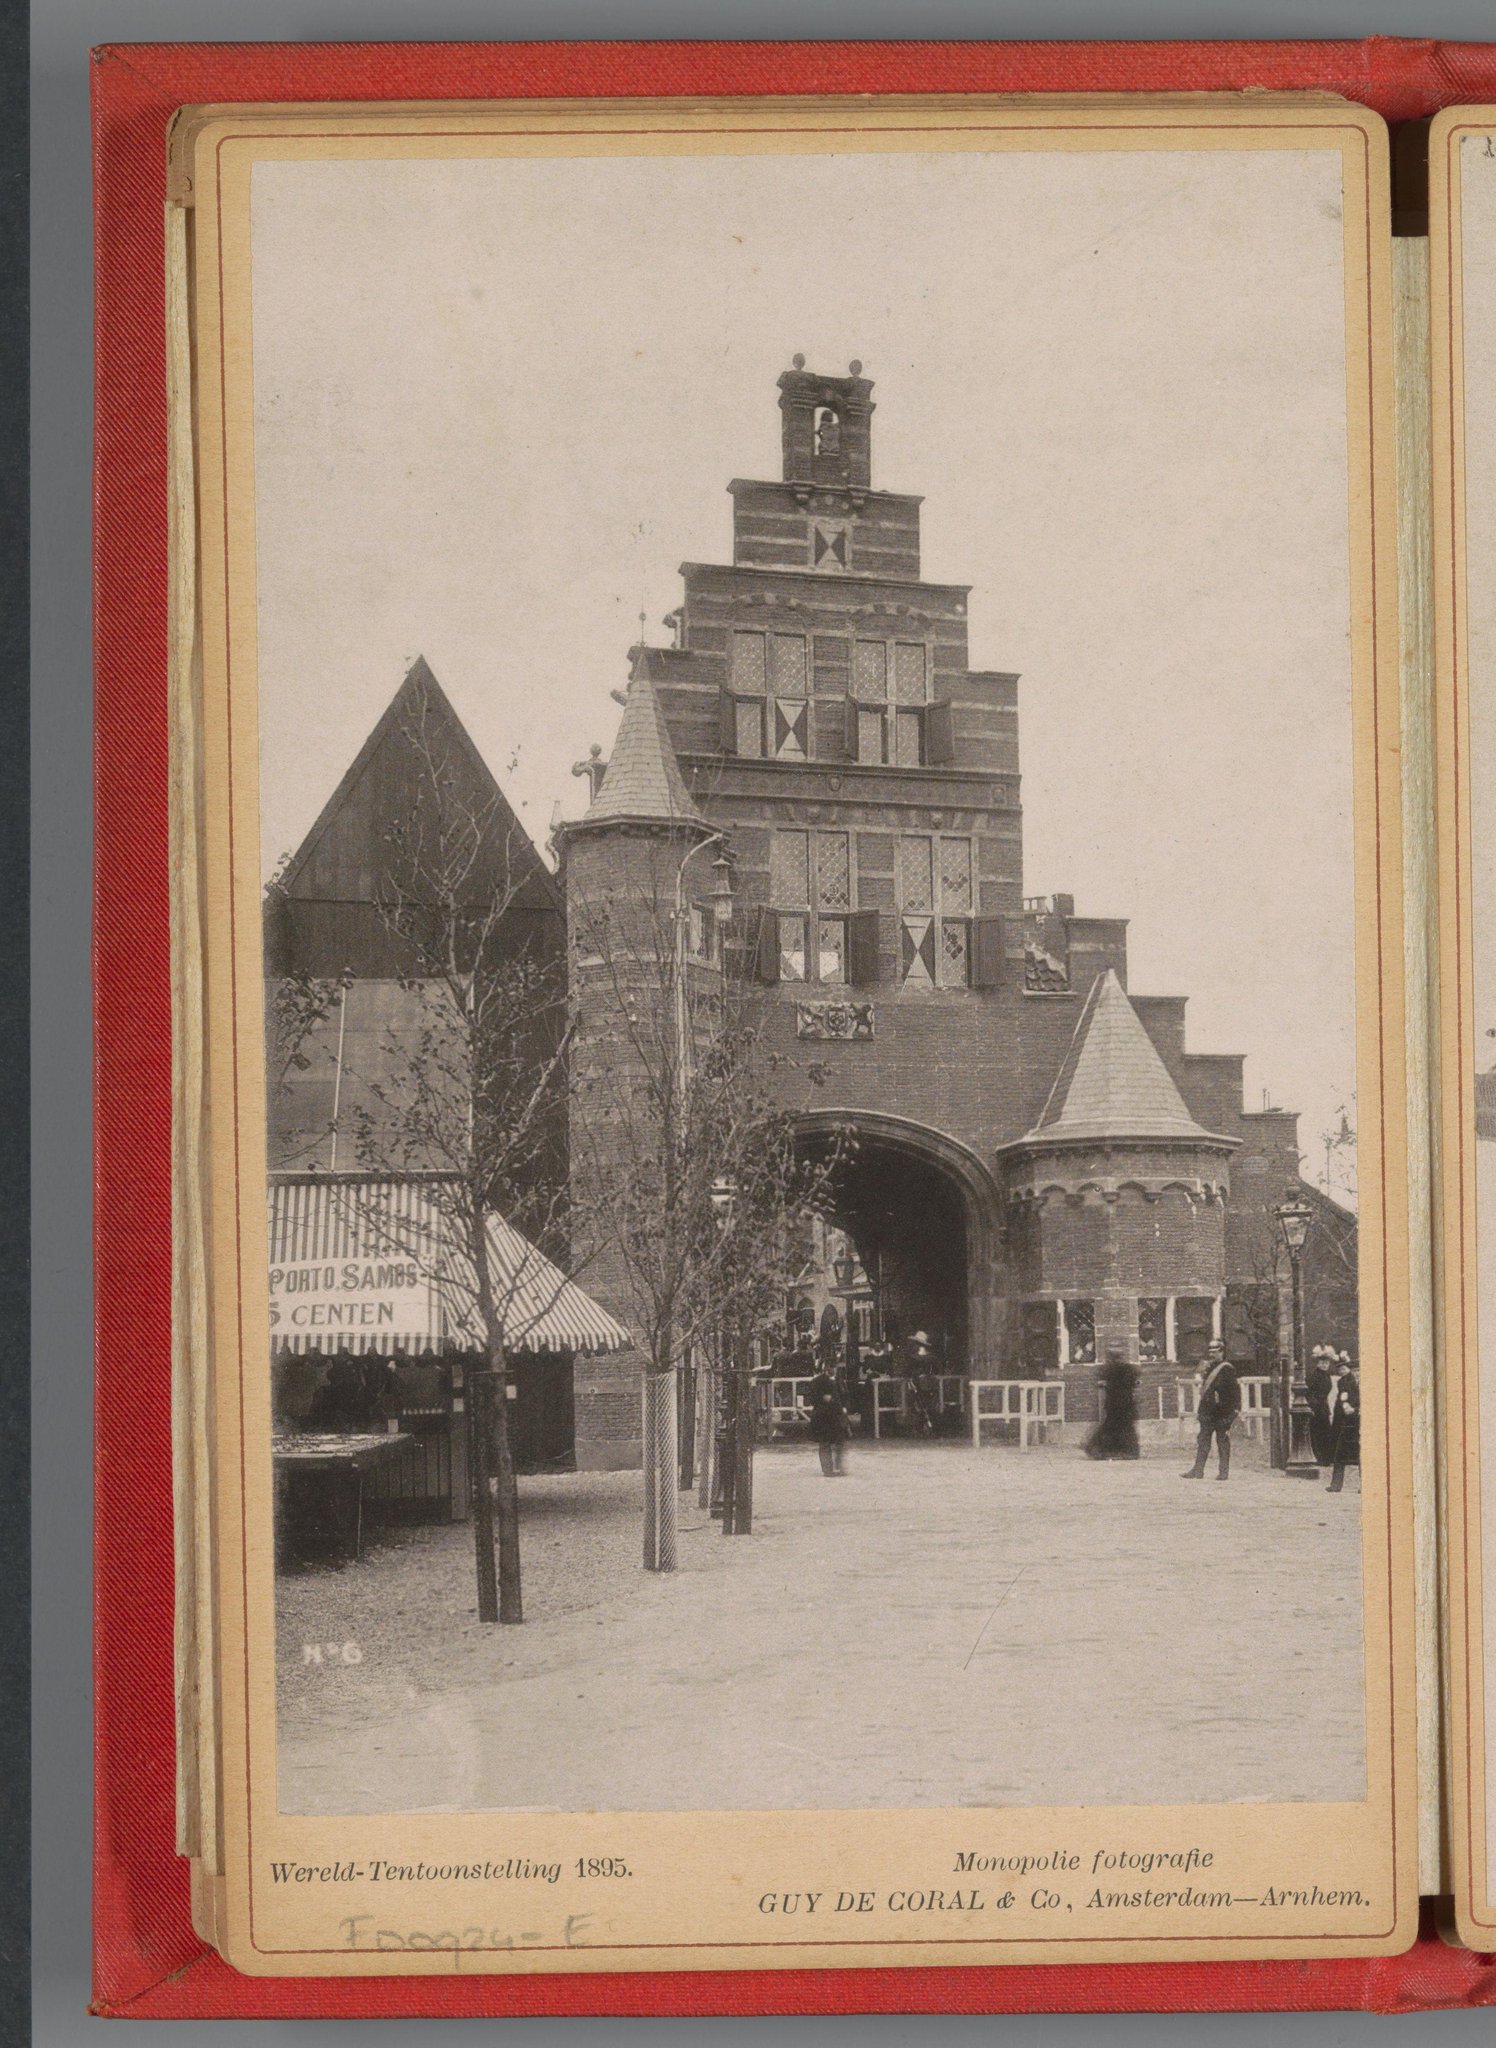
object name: photograph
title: Replica van een stadspoort tijdens de Wereldtentoonstelling voor het Hotel- en Reiswezen op het Museumplein in 1895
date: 1895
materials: cardboard, paper, ink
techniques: photograph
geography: amsterdam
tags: gate, entrance, prospect of city, town panorama, silhouette of city, temporary exhibition, 'salon', amsterdam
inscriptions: number: ‘No. 6’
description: Onderdeel van Fotoalbum met opnames van de Wereldtentoonstelling voor het Hotel- en Reiswezen op het Museumplein in 1895.